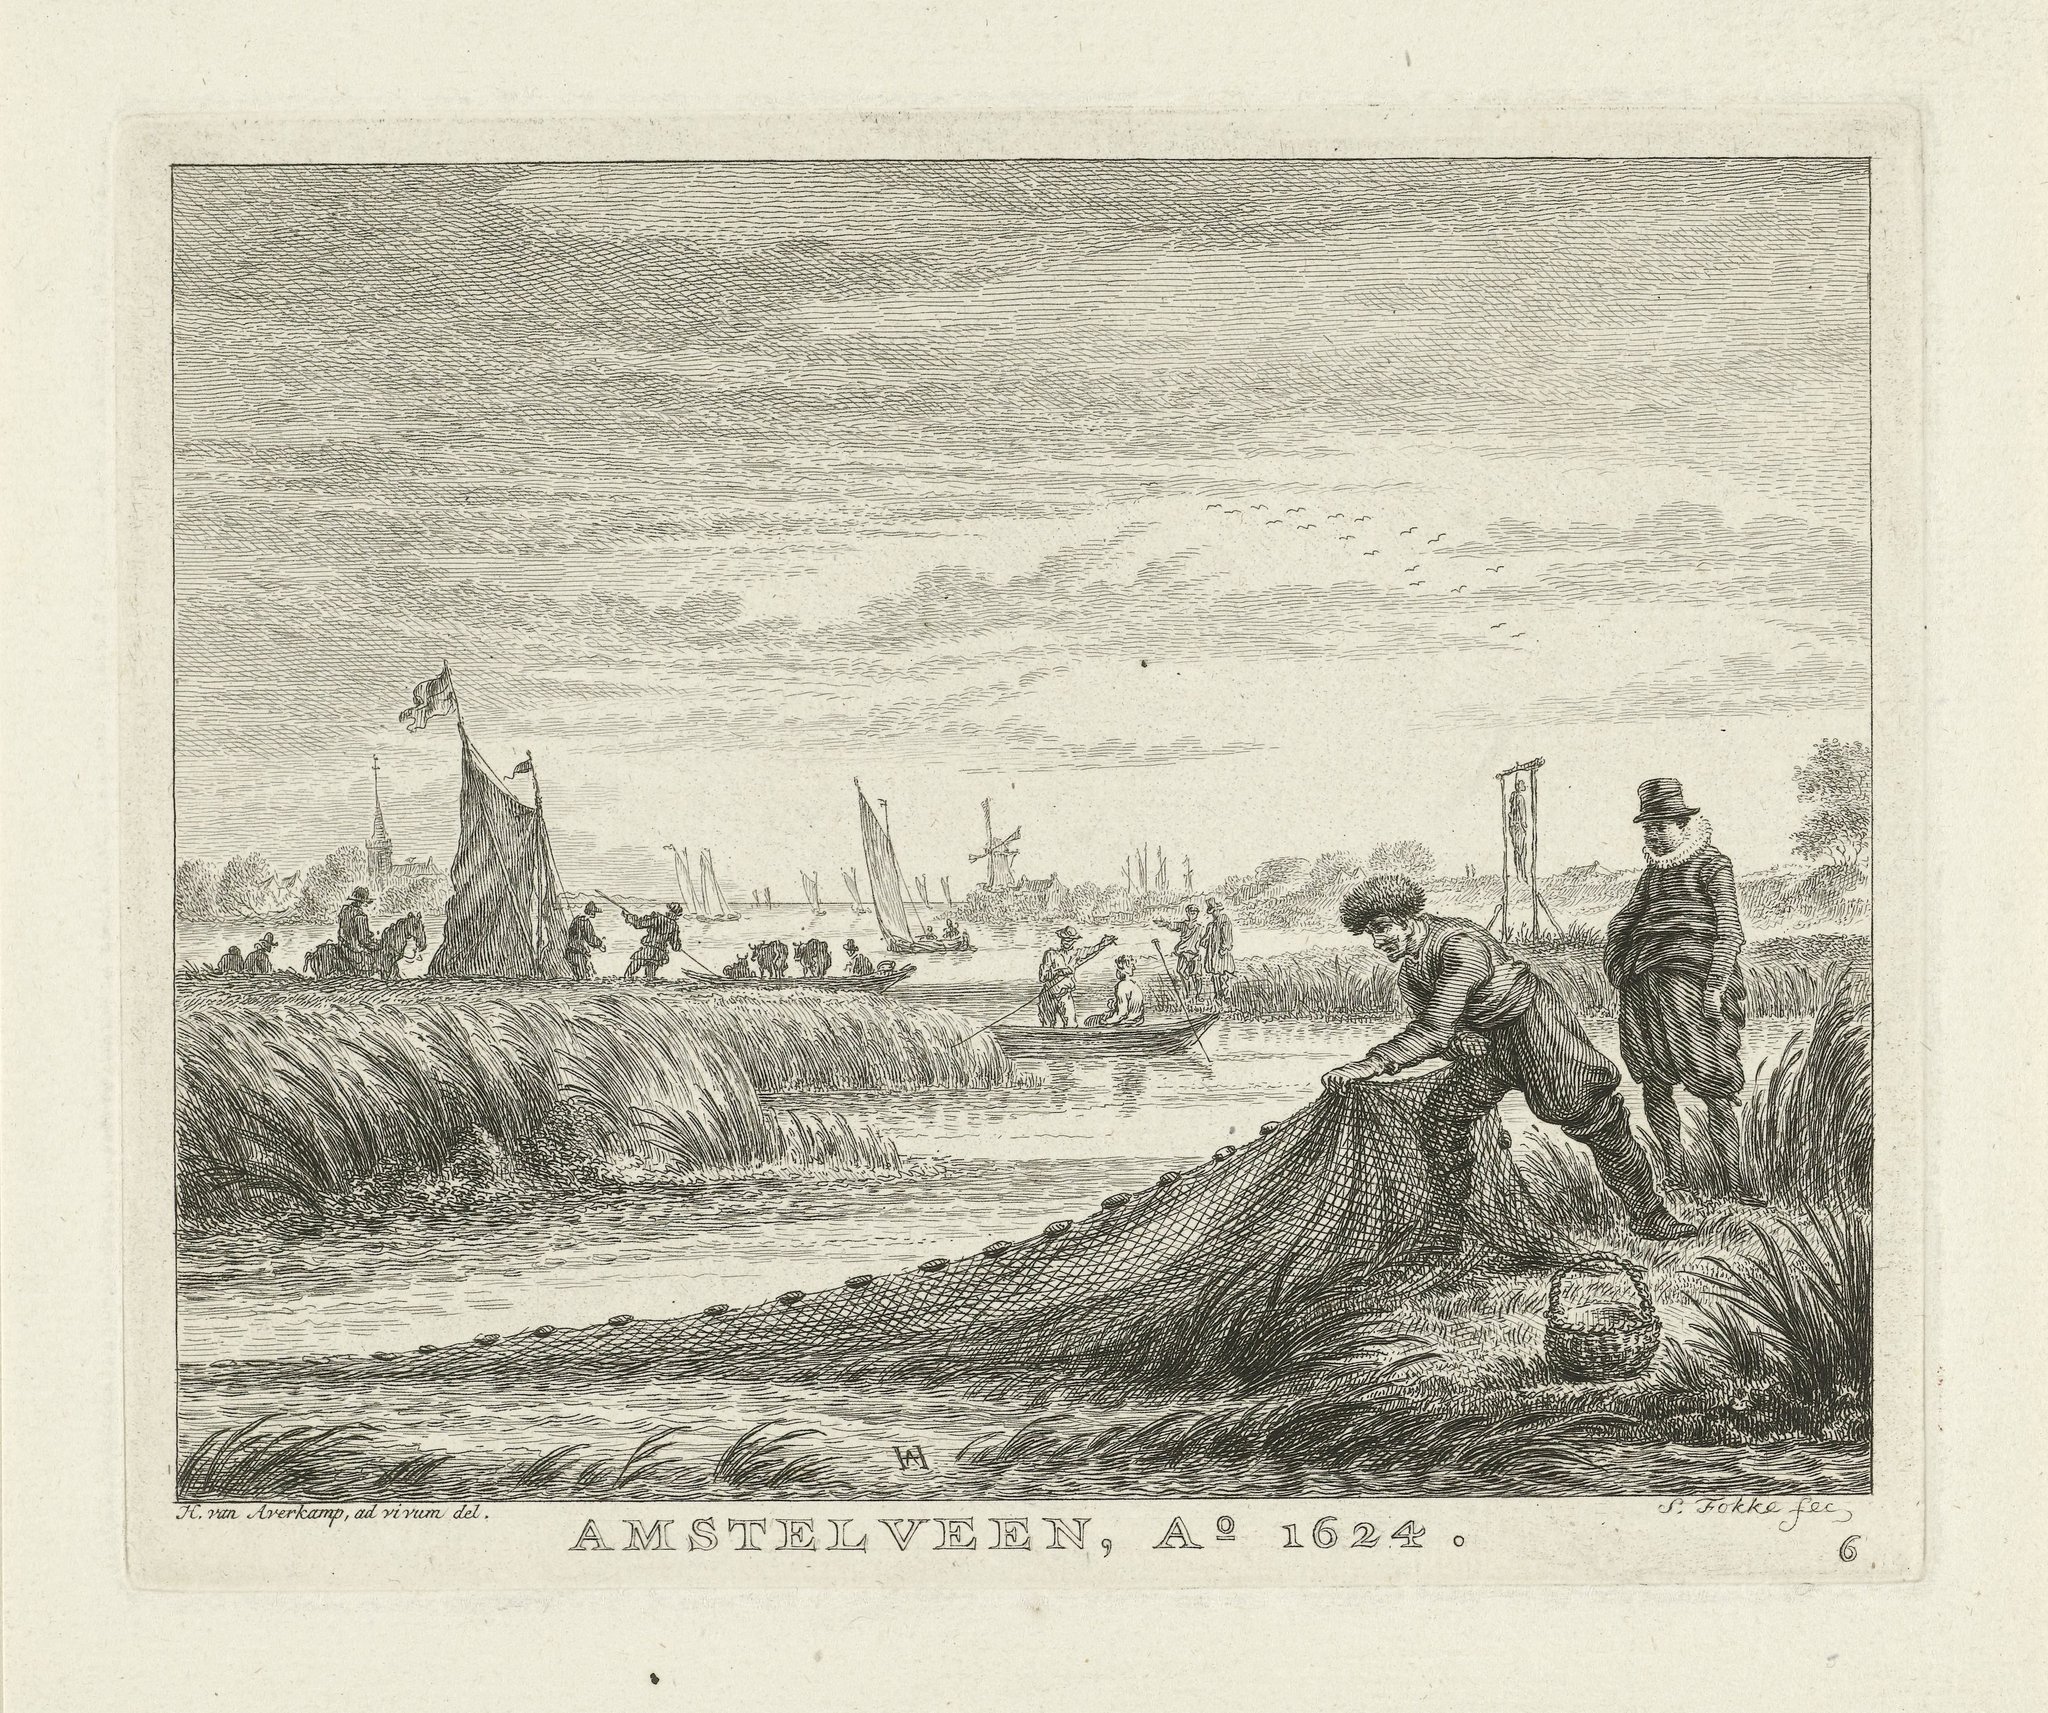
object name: print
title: Rivierlandschap met boten nabij Amstelveen, 1624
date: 1722-1784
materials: paper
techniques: etching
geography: amsterdam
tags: sailing-ship, sailing-boat, river bank, fisherman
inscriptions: collector's mark: Lugt 240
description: Rivierlandschap met boten nabij Amstelveen. Op de oever kijkt een figuur toe hoe een visser zijn visnet op het droge trekt. Op een oever verderop hangt een lijk aan de galg. In de verte een molen en de kerktoren van Amstelveen.